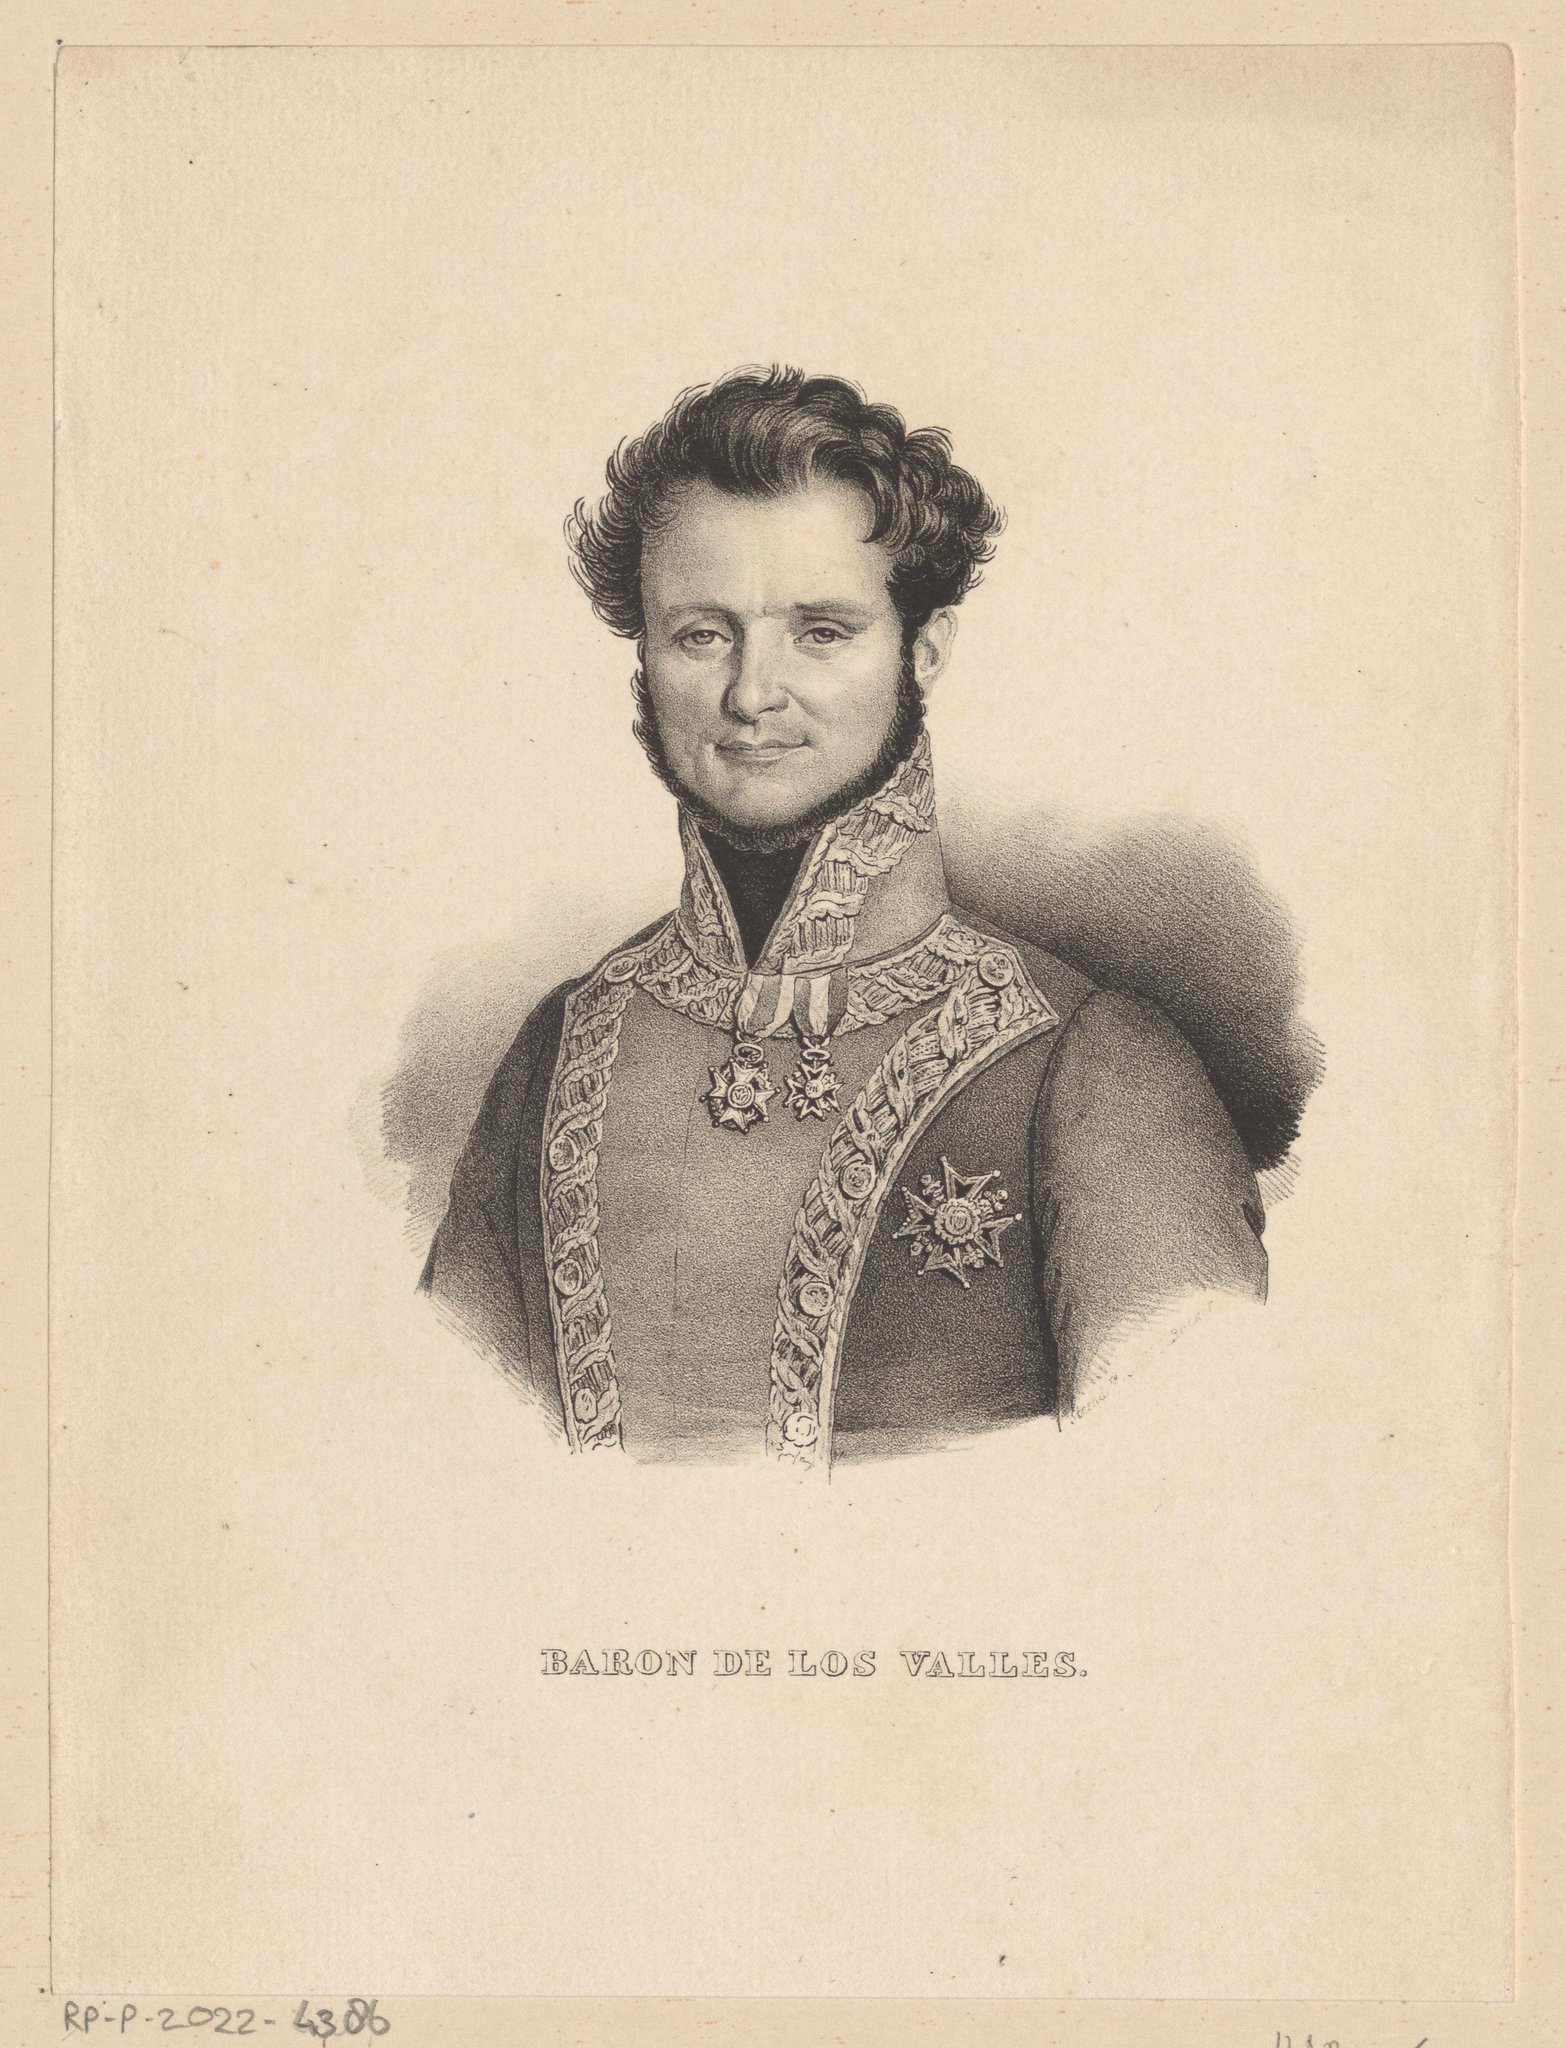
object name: print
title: Baron de los Valles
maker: Anonymous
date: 1833-1846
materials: paper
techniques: lithograph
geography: northern netherlands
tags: historical persons, medals and other marks of military honour